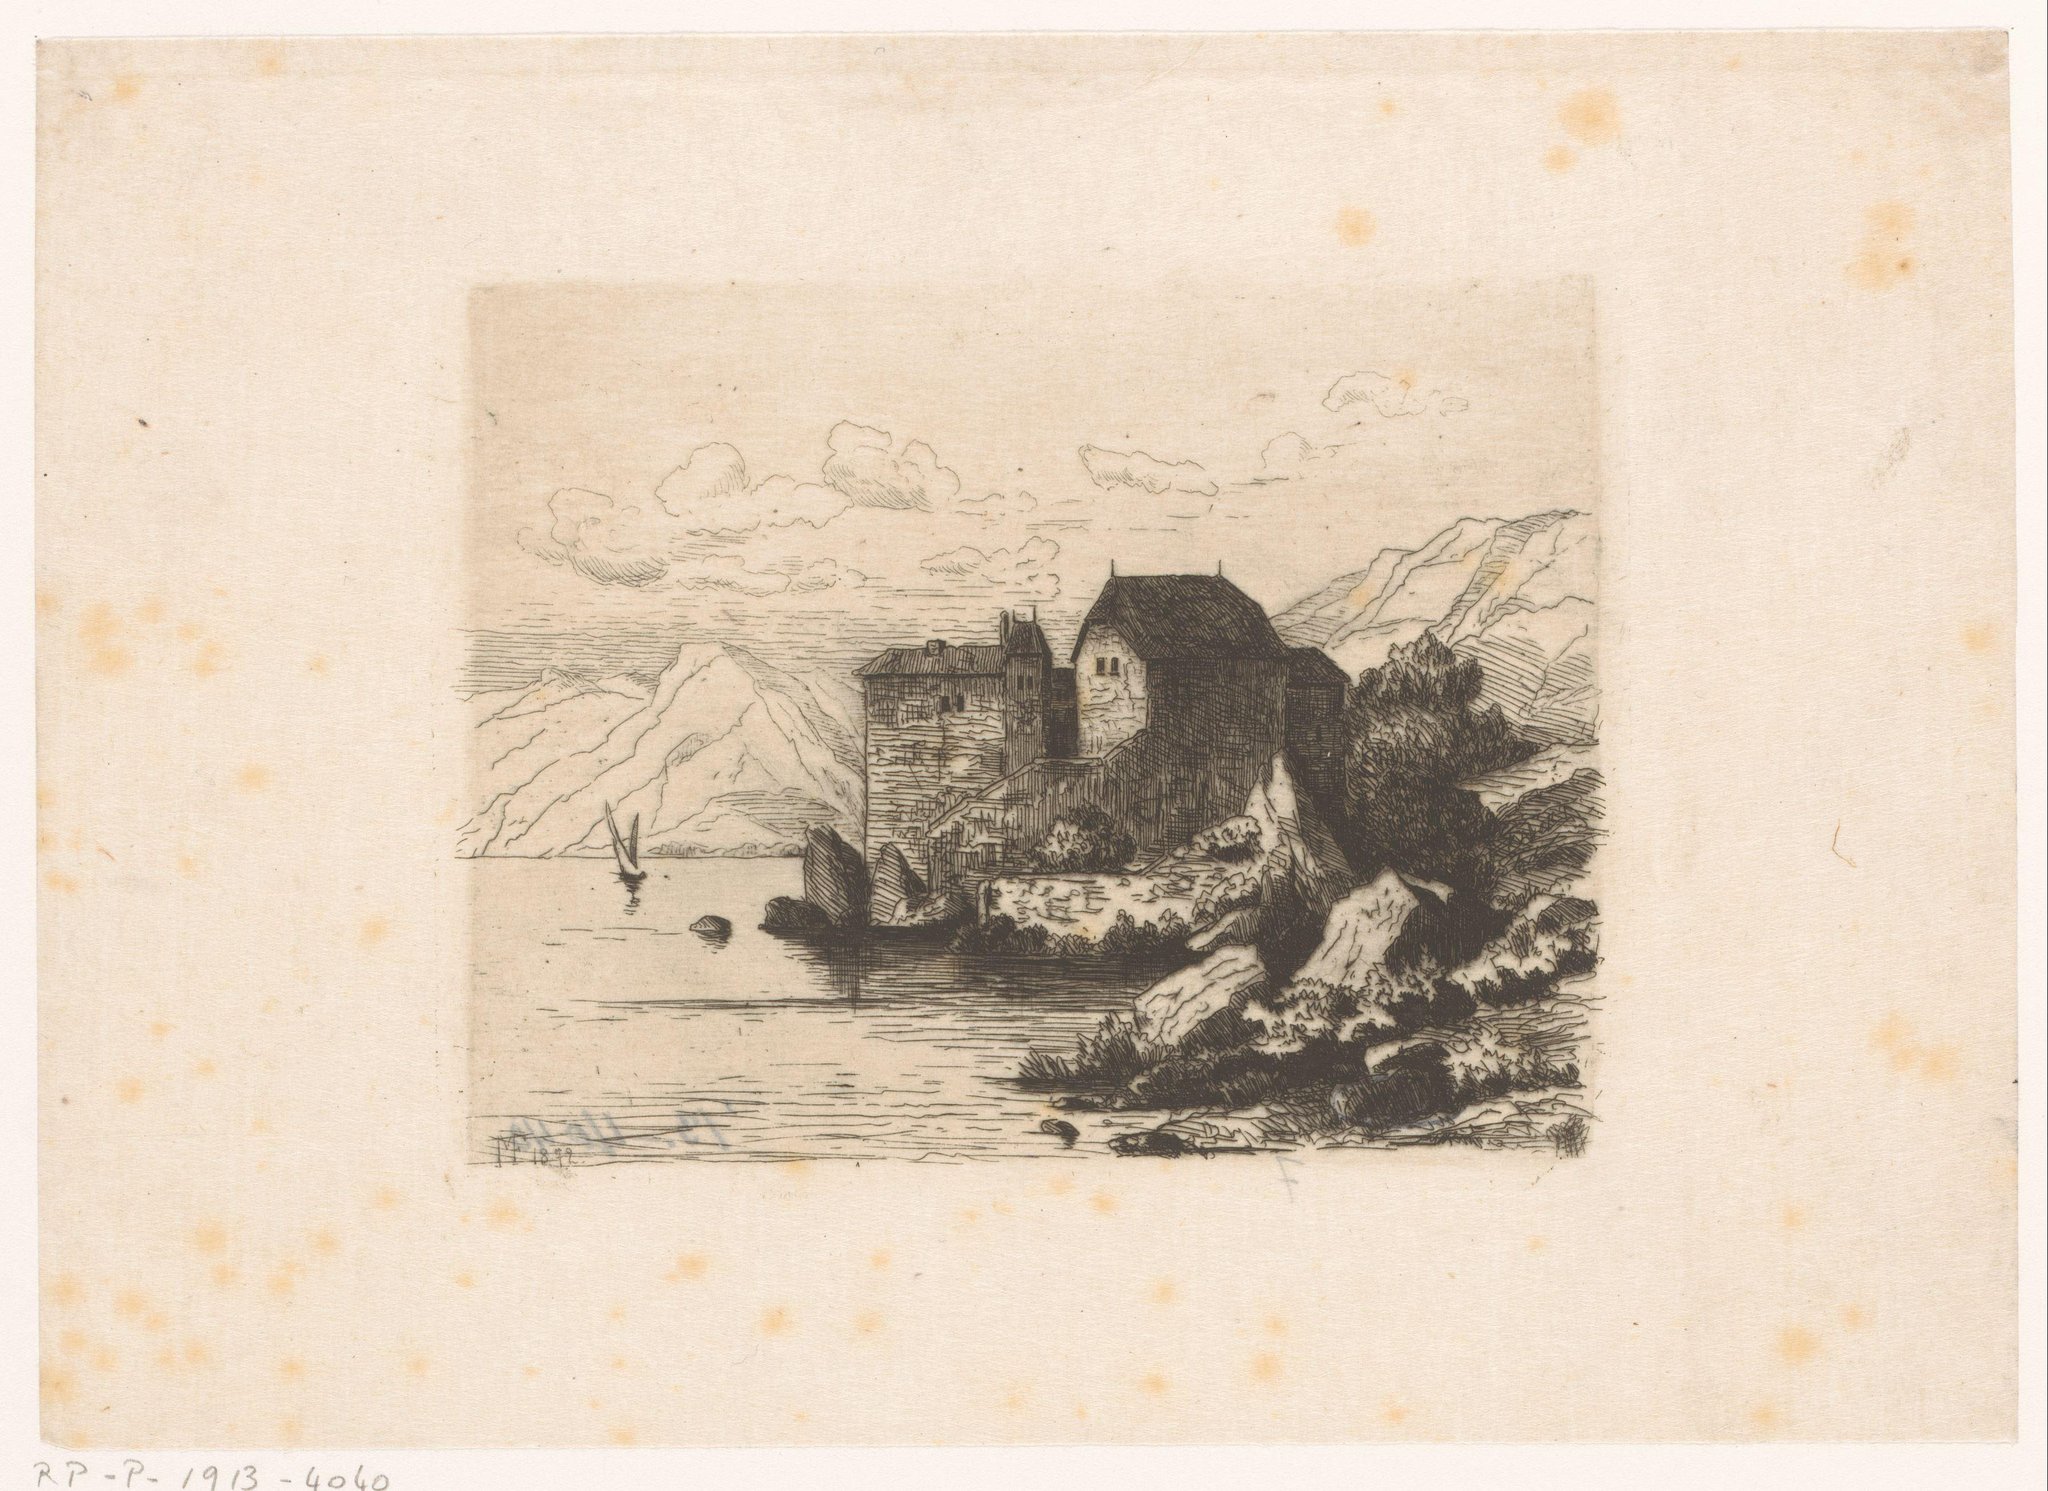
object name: print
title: Landhuis aan de oever van een meer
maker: maria van hohenzollern-sigmaringen (gravin van vlaanderen)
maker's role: print maker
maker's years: 1845-1912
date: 1872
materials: paper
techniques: drypoint, etching, intaglio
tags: city-view, and landscape with man-made constructions, lake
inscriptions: collector's mark: Lugt 2228